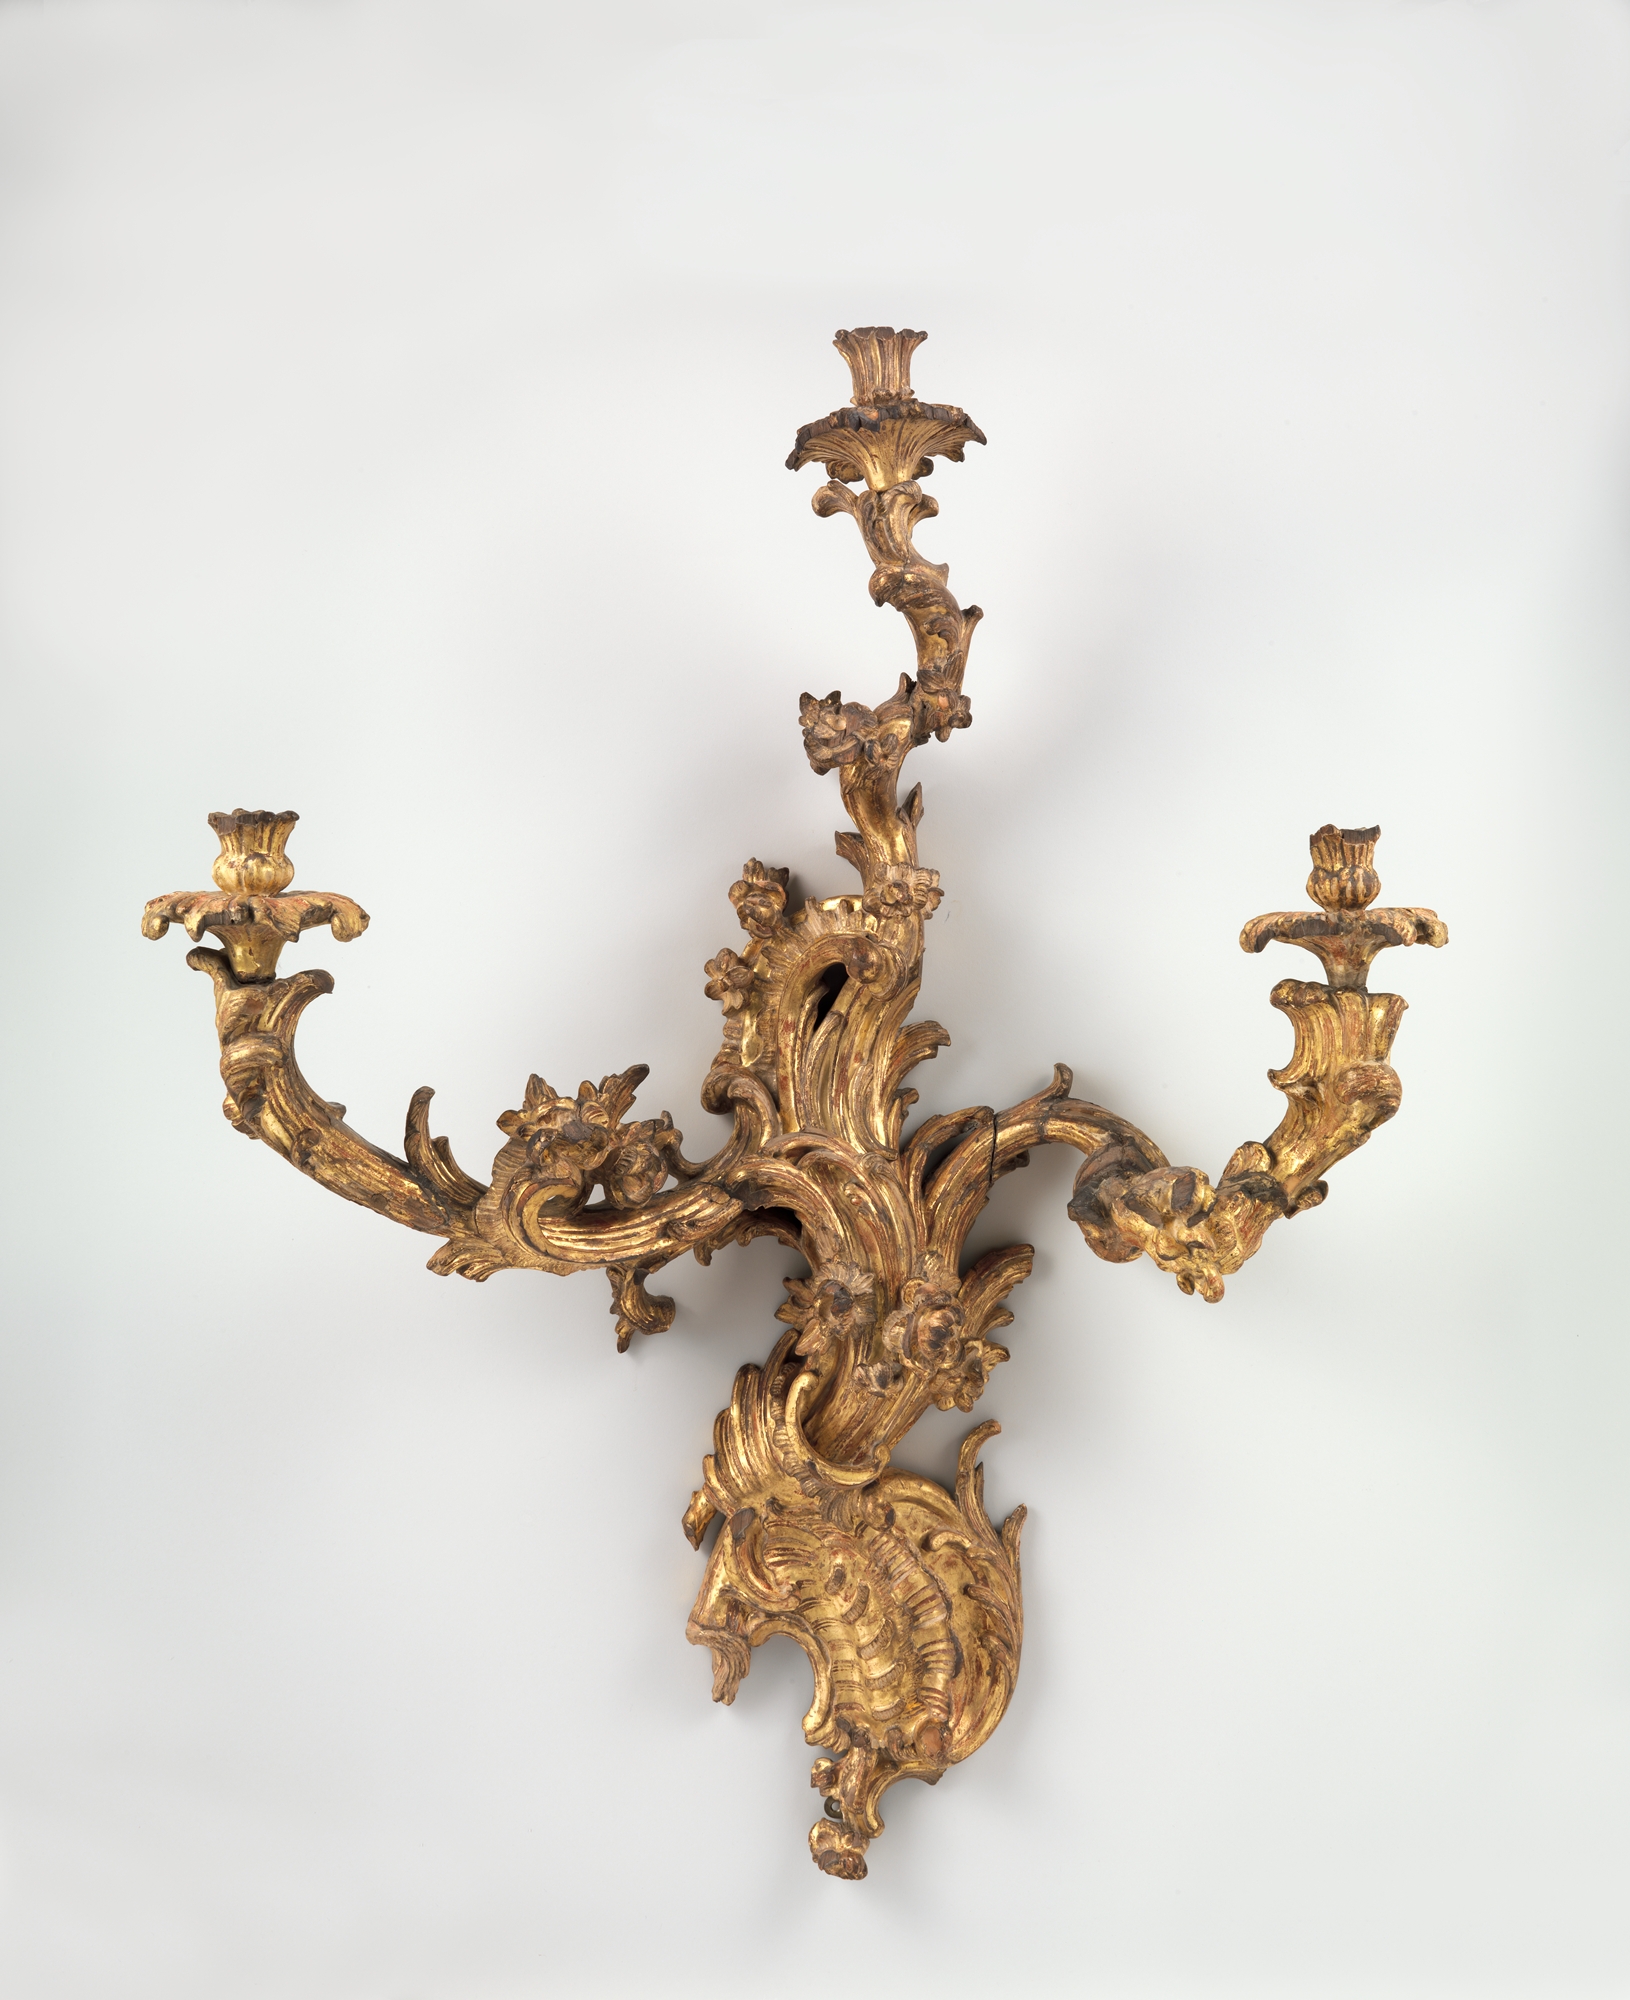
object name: wall light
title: Wall light (candelabrum appliqué) (one of a pair)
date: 1735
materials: wood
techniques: carving, gilding